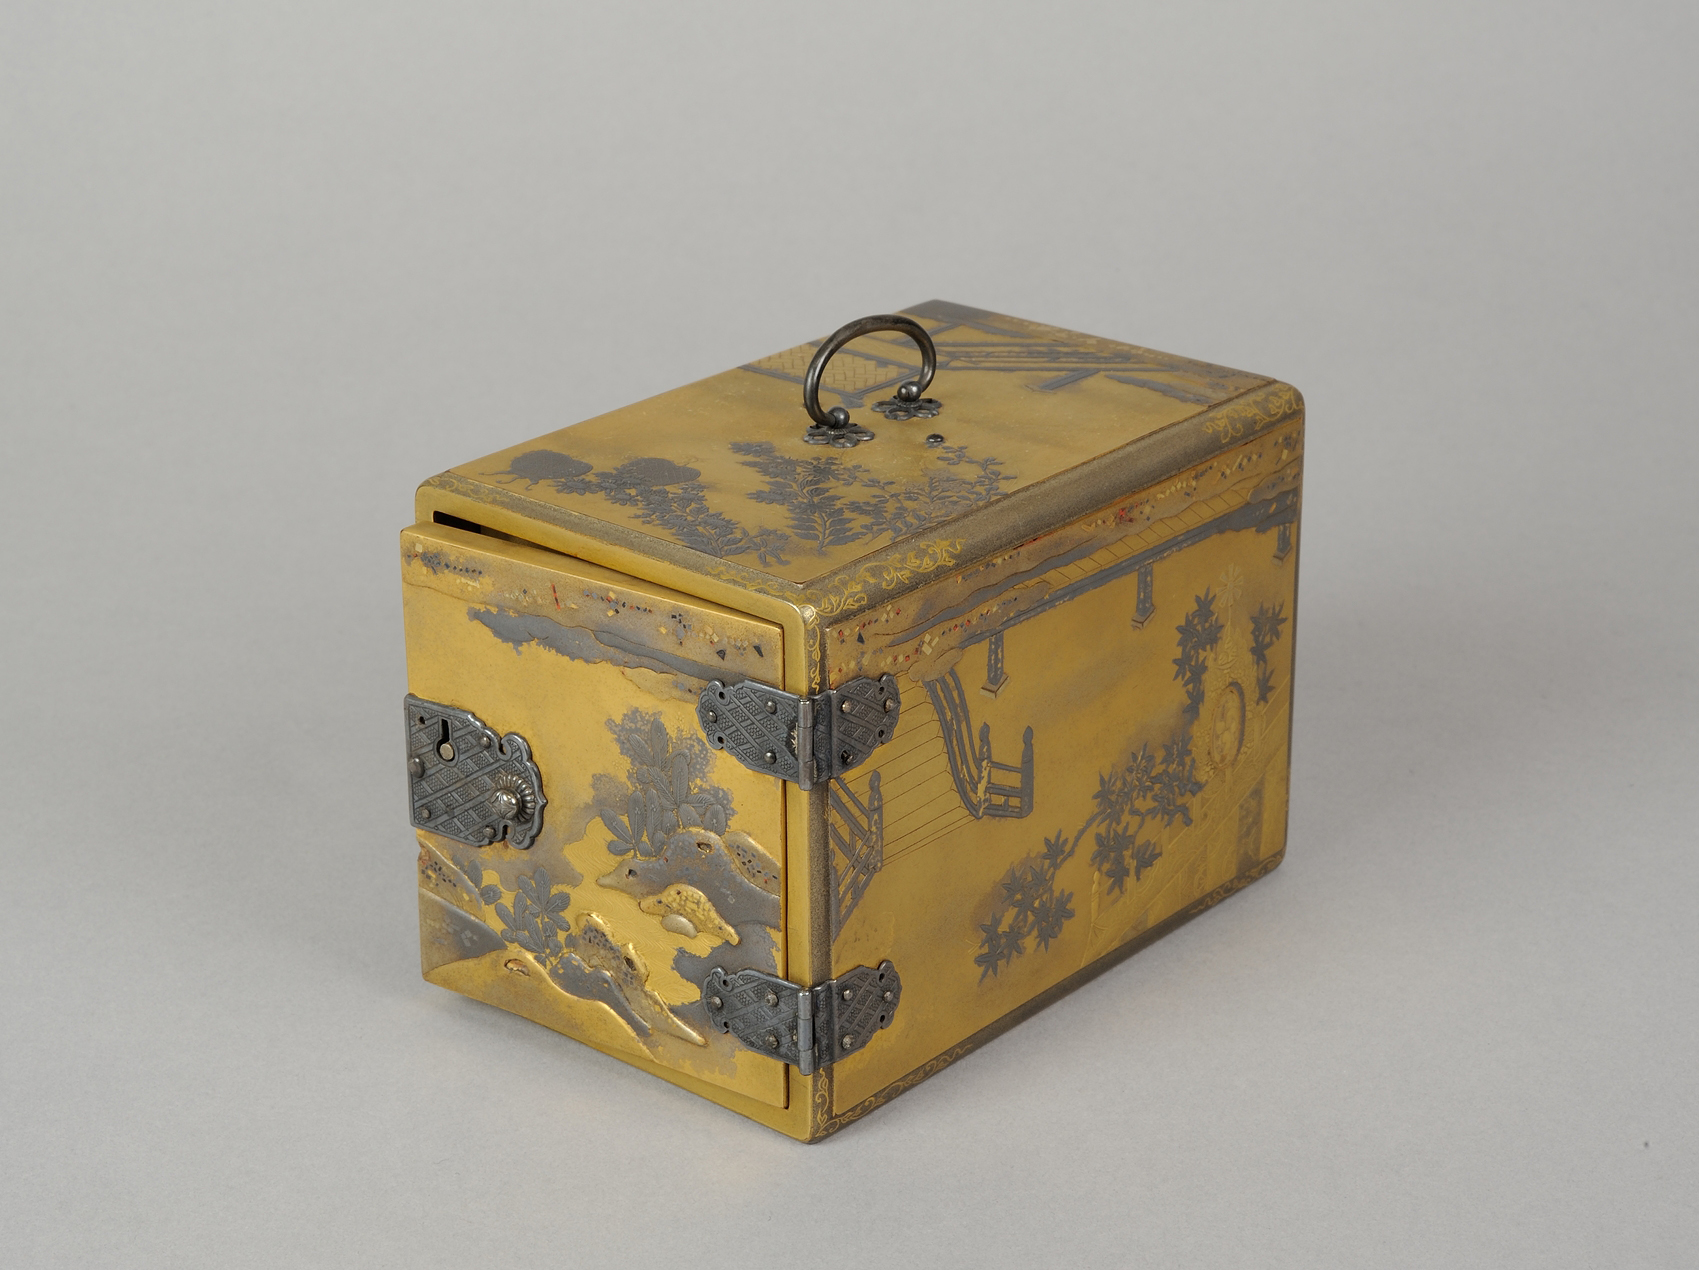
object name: chest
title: Small Chest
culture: japanese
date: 1834-1866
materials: gold, gold foil, gold leaf, silver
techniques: cutting, hiramakie, maki-e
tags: chests